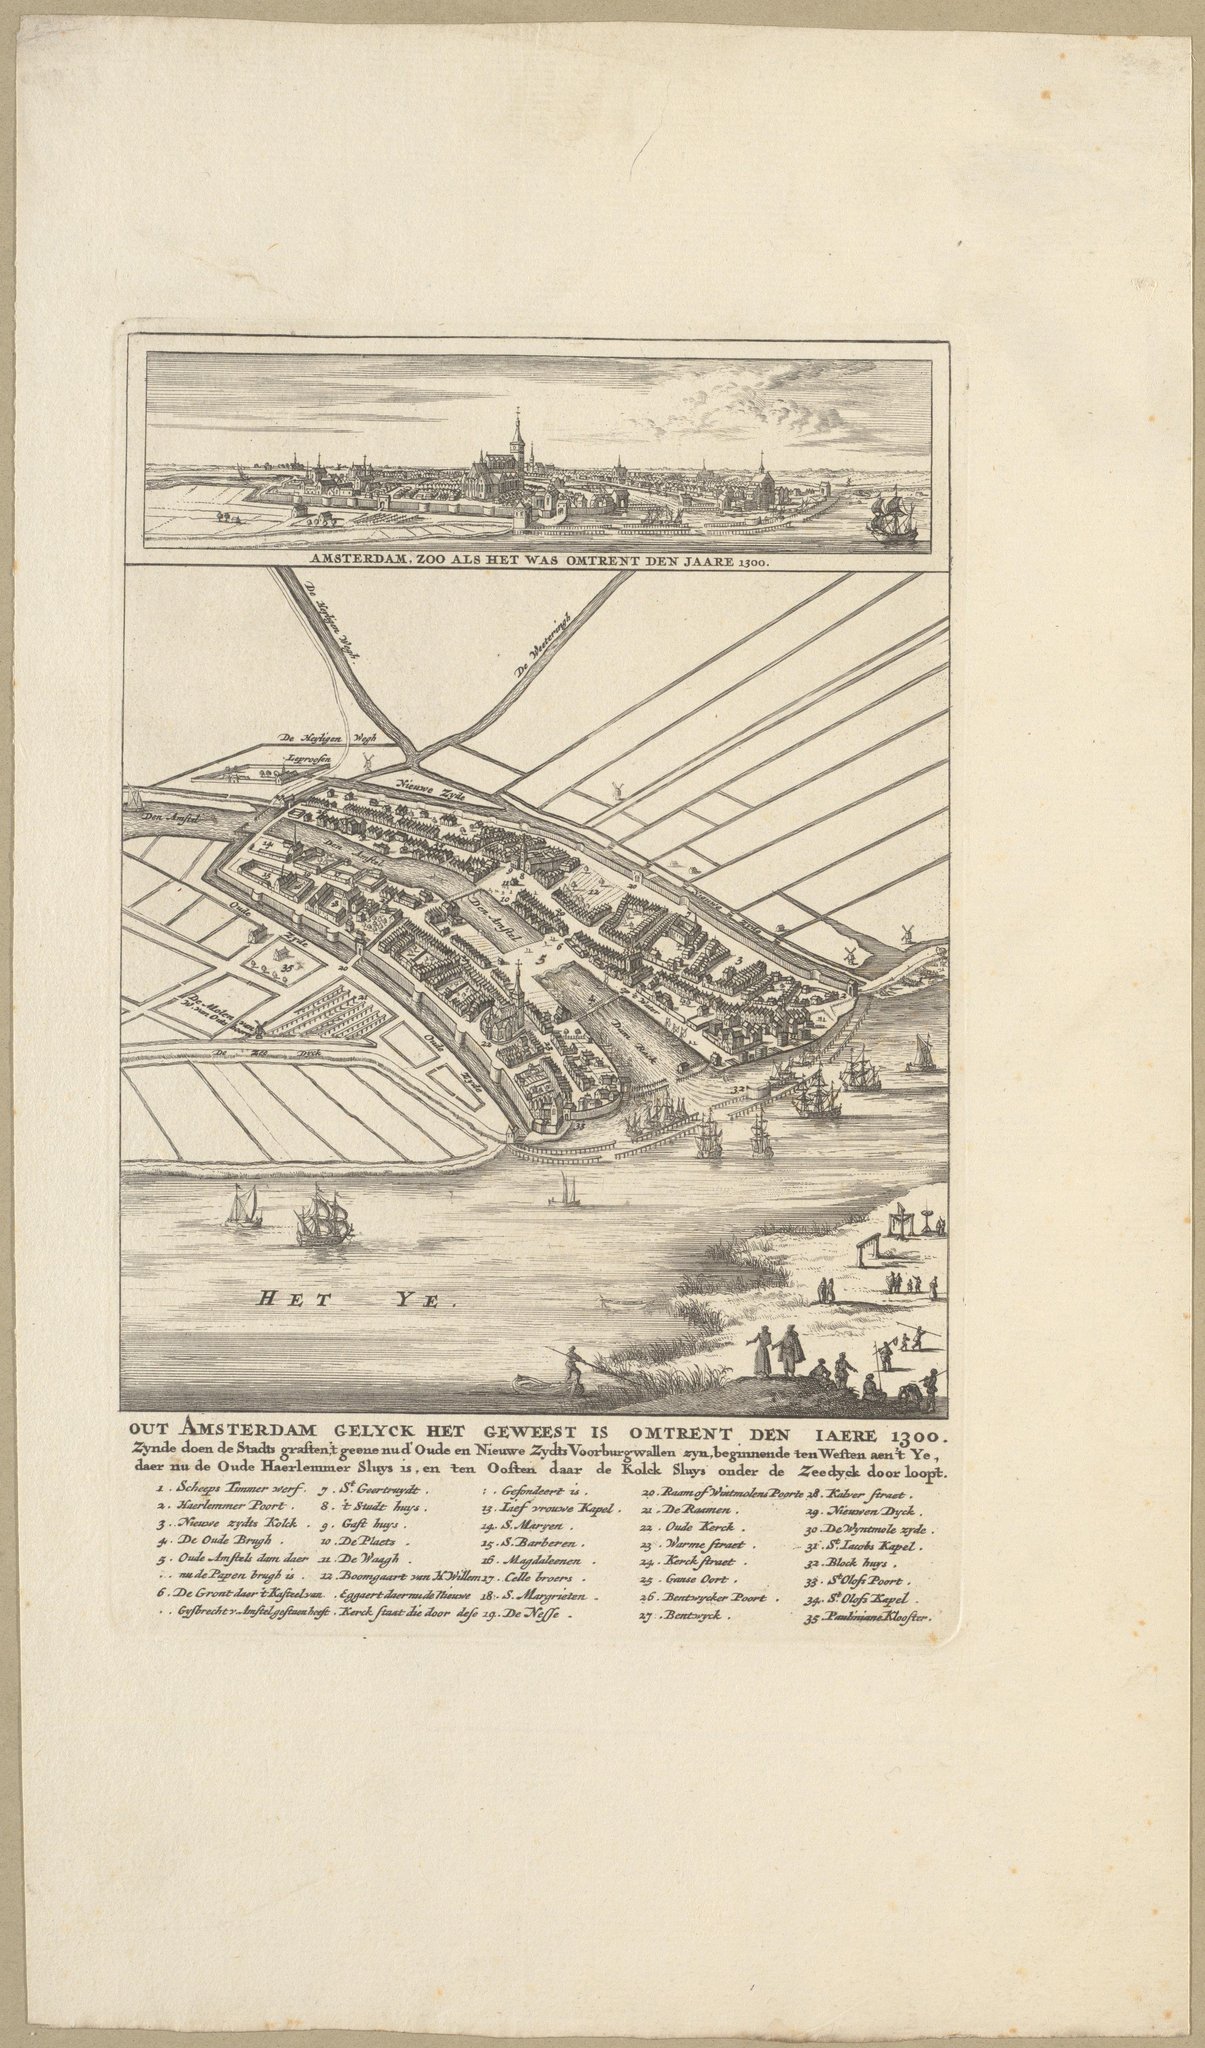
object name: print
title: Amsterdam, zoo als het was omtrent den jaare 1300 / Out Amsterdam gelyck het geweest is omtrent den iaere 1300 (...)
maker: jan luyken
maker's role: draughtsman, print maker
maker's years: 1649-1712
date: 1726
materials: paper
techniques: engraving, etching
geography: northern netherlands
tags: maps of cities, prospect of city, town panorama, silhouette of city, amsterdam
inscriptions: collector's mark: Lugt 1641b